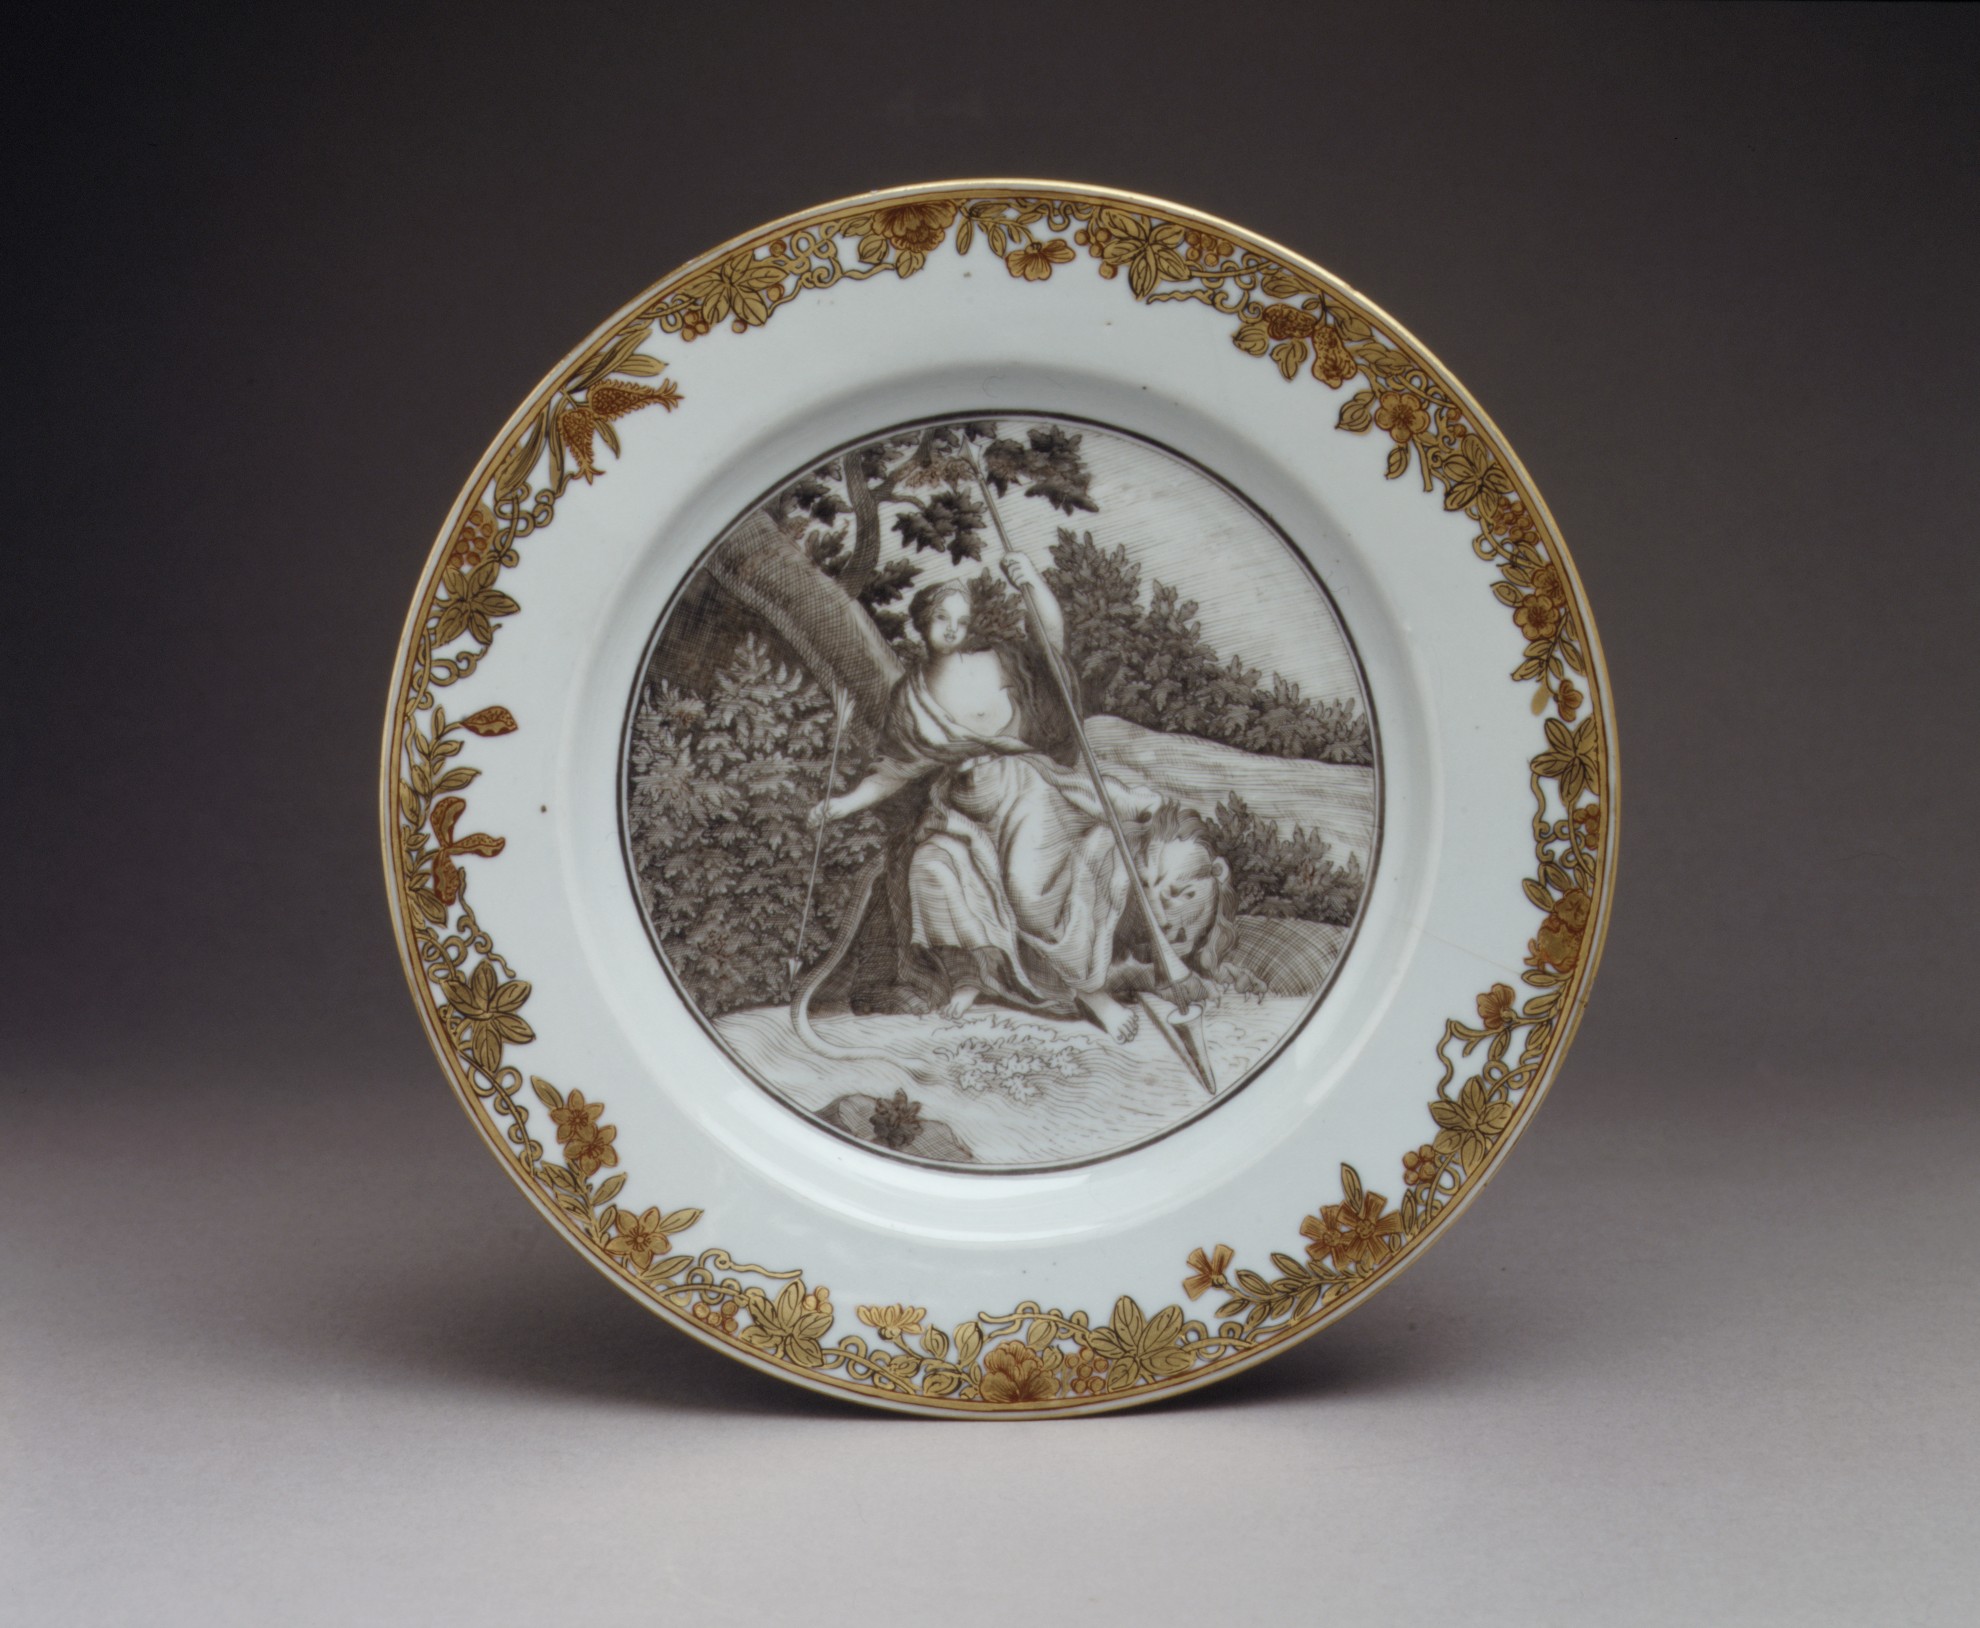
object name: soup plate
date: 1740-1750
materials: hard paste porcelain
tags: animals,arrows,spears,women